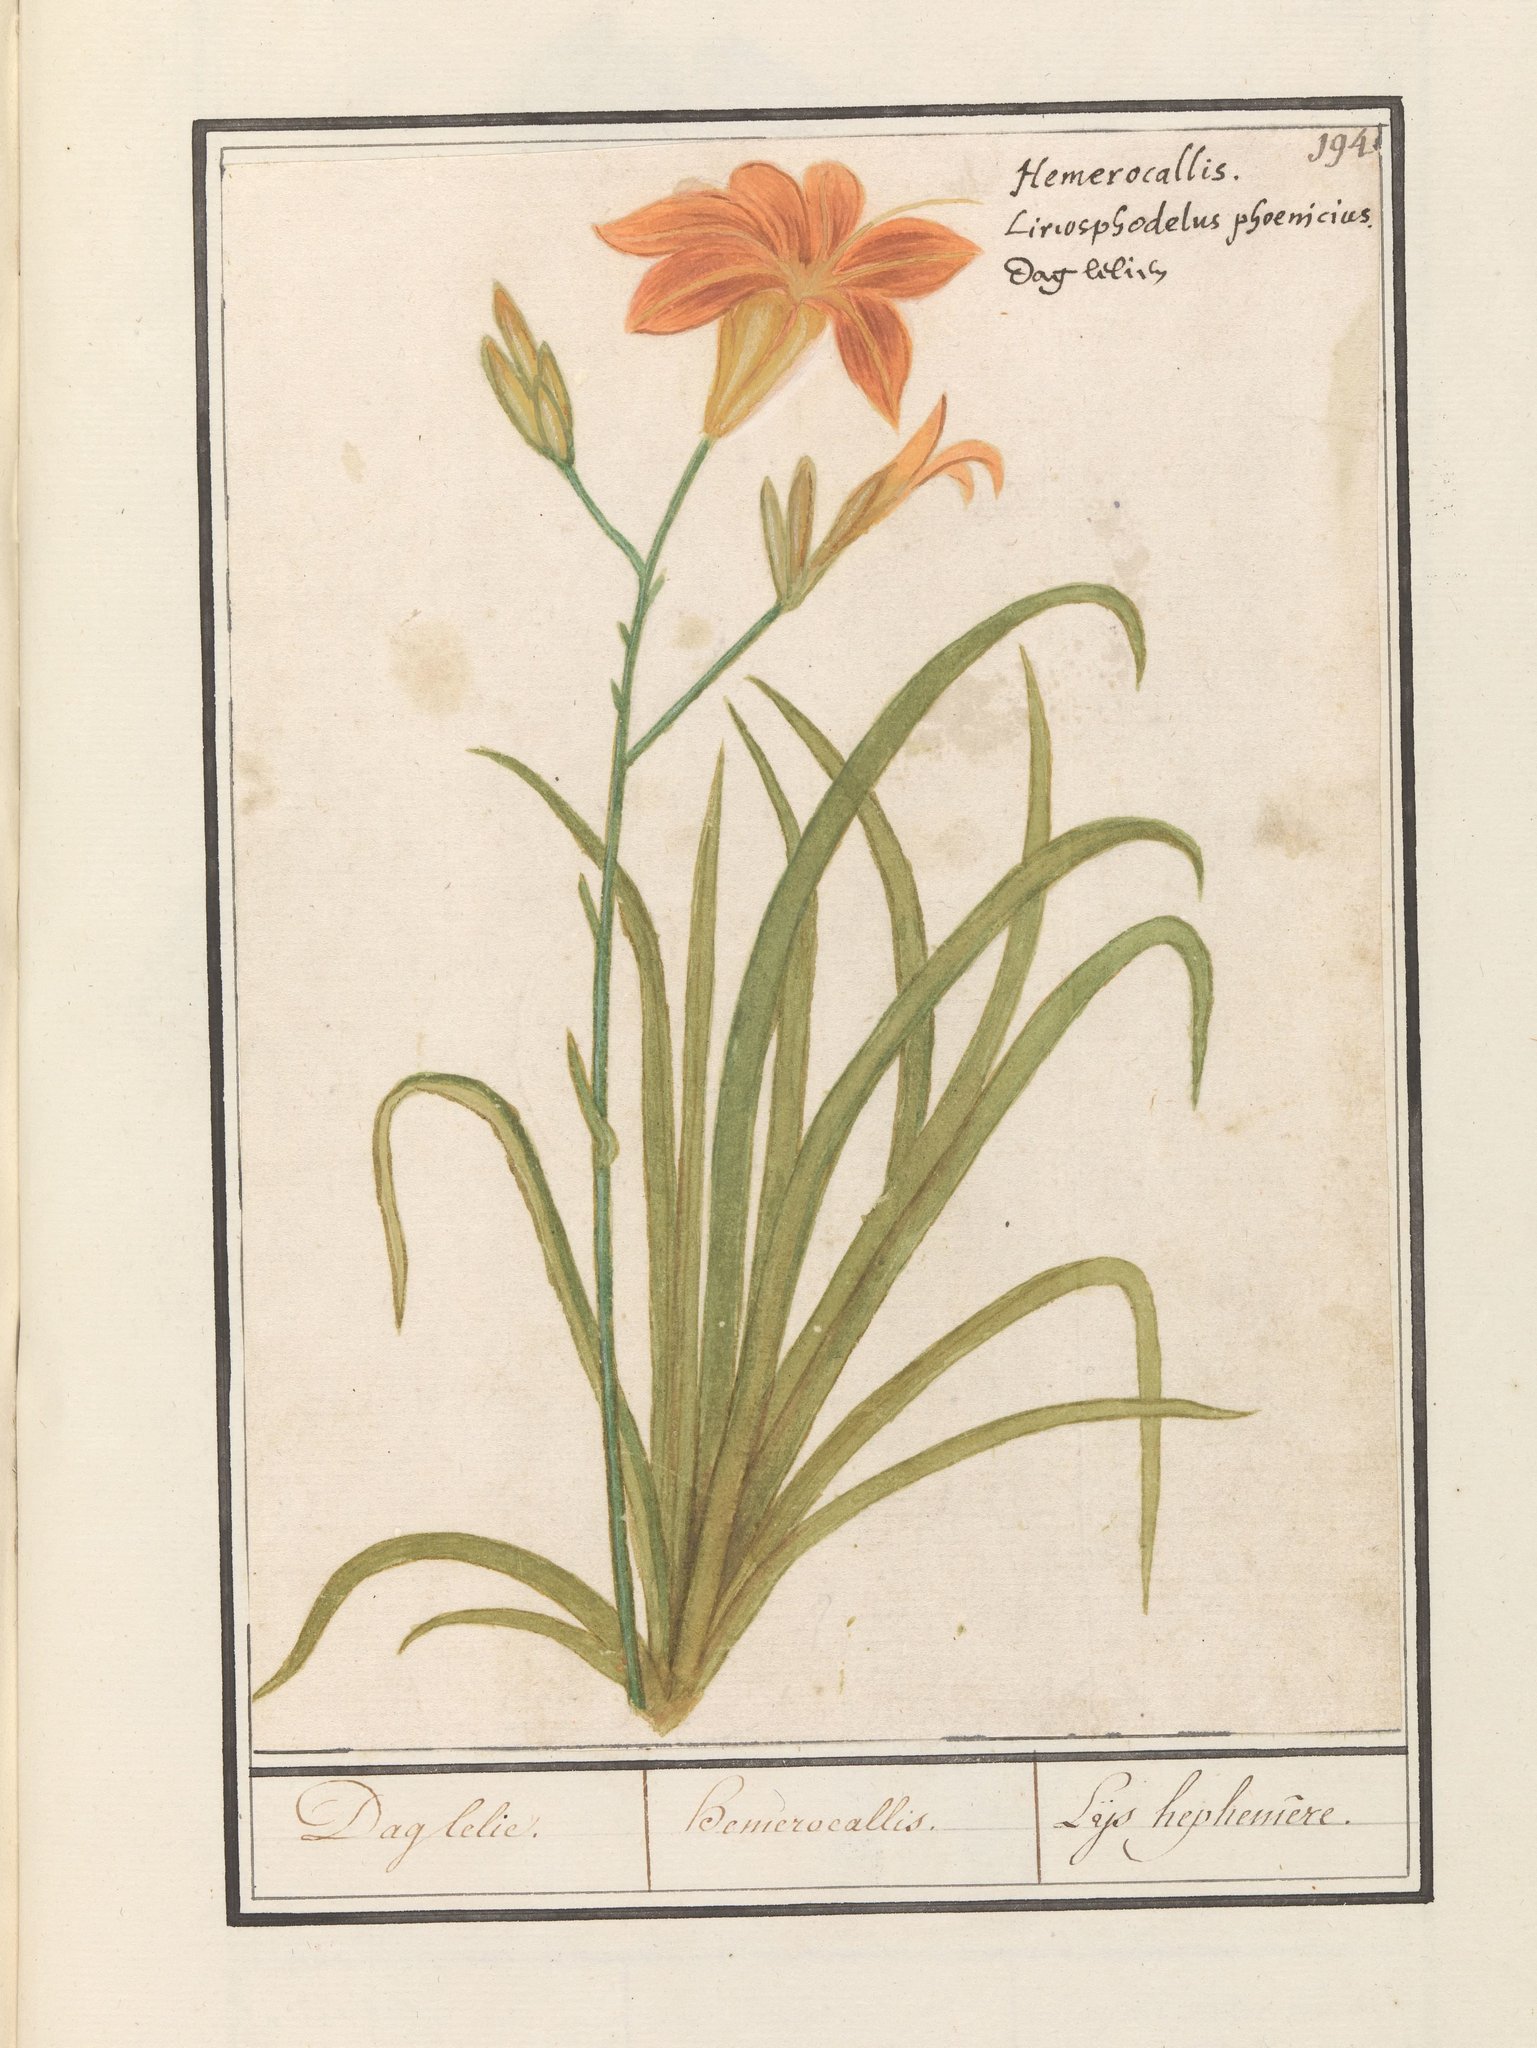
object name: drawing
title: Dag lelie. / hemerocallis. / Leys hephemere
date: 1596-1610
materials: chalk, paint, ink, paper, watercolor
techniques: brush, pen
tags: flowers: lily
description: Oranje daglelie. Rechtsboven genummerd: 194. Rechtsboven de Latijnse en Nederlandse naam. Onderdeel van het tweede album met tekeningen van bloemen en planten. Negende van twaalf albums met tekeningen van dieren, vogels en planten bekend rond 1600, gemaakt in opdracht van keizer Rudolf II. Met toelichting in Nederlands, Latijn en Frans.